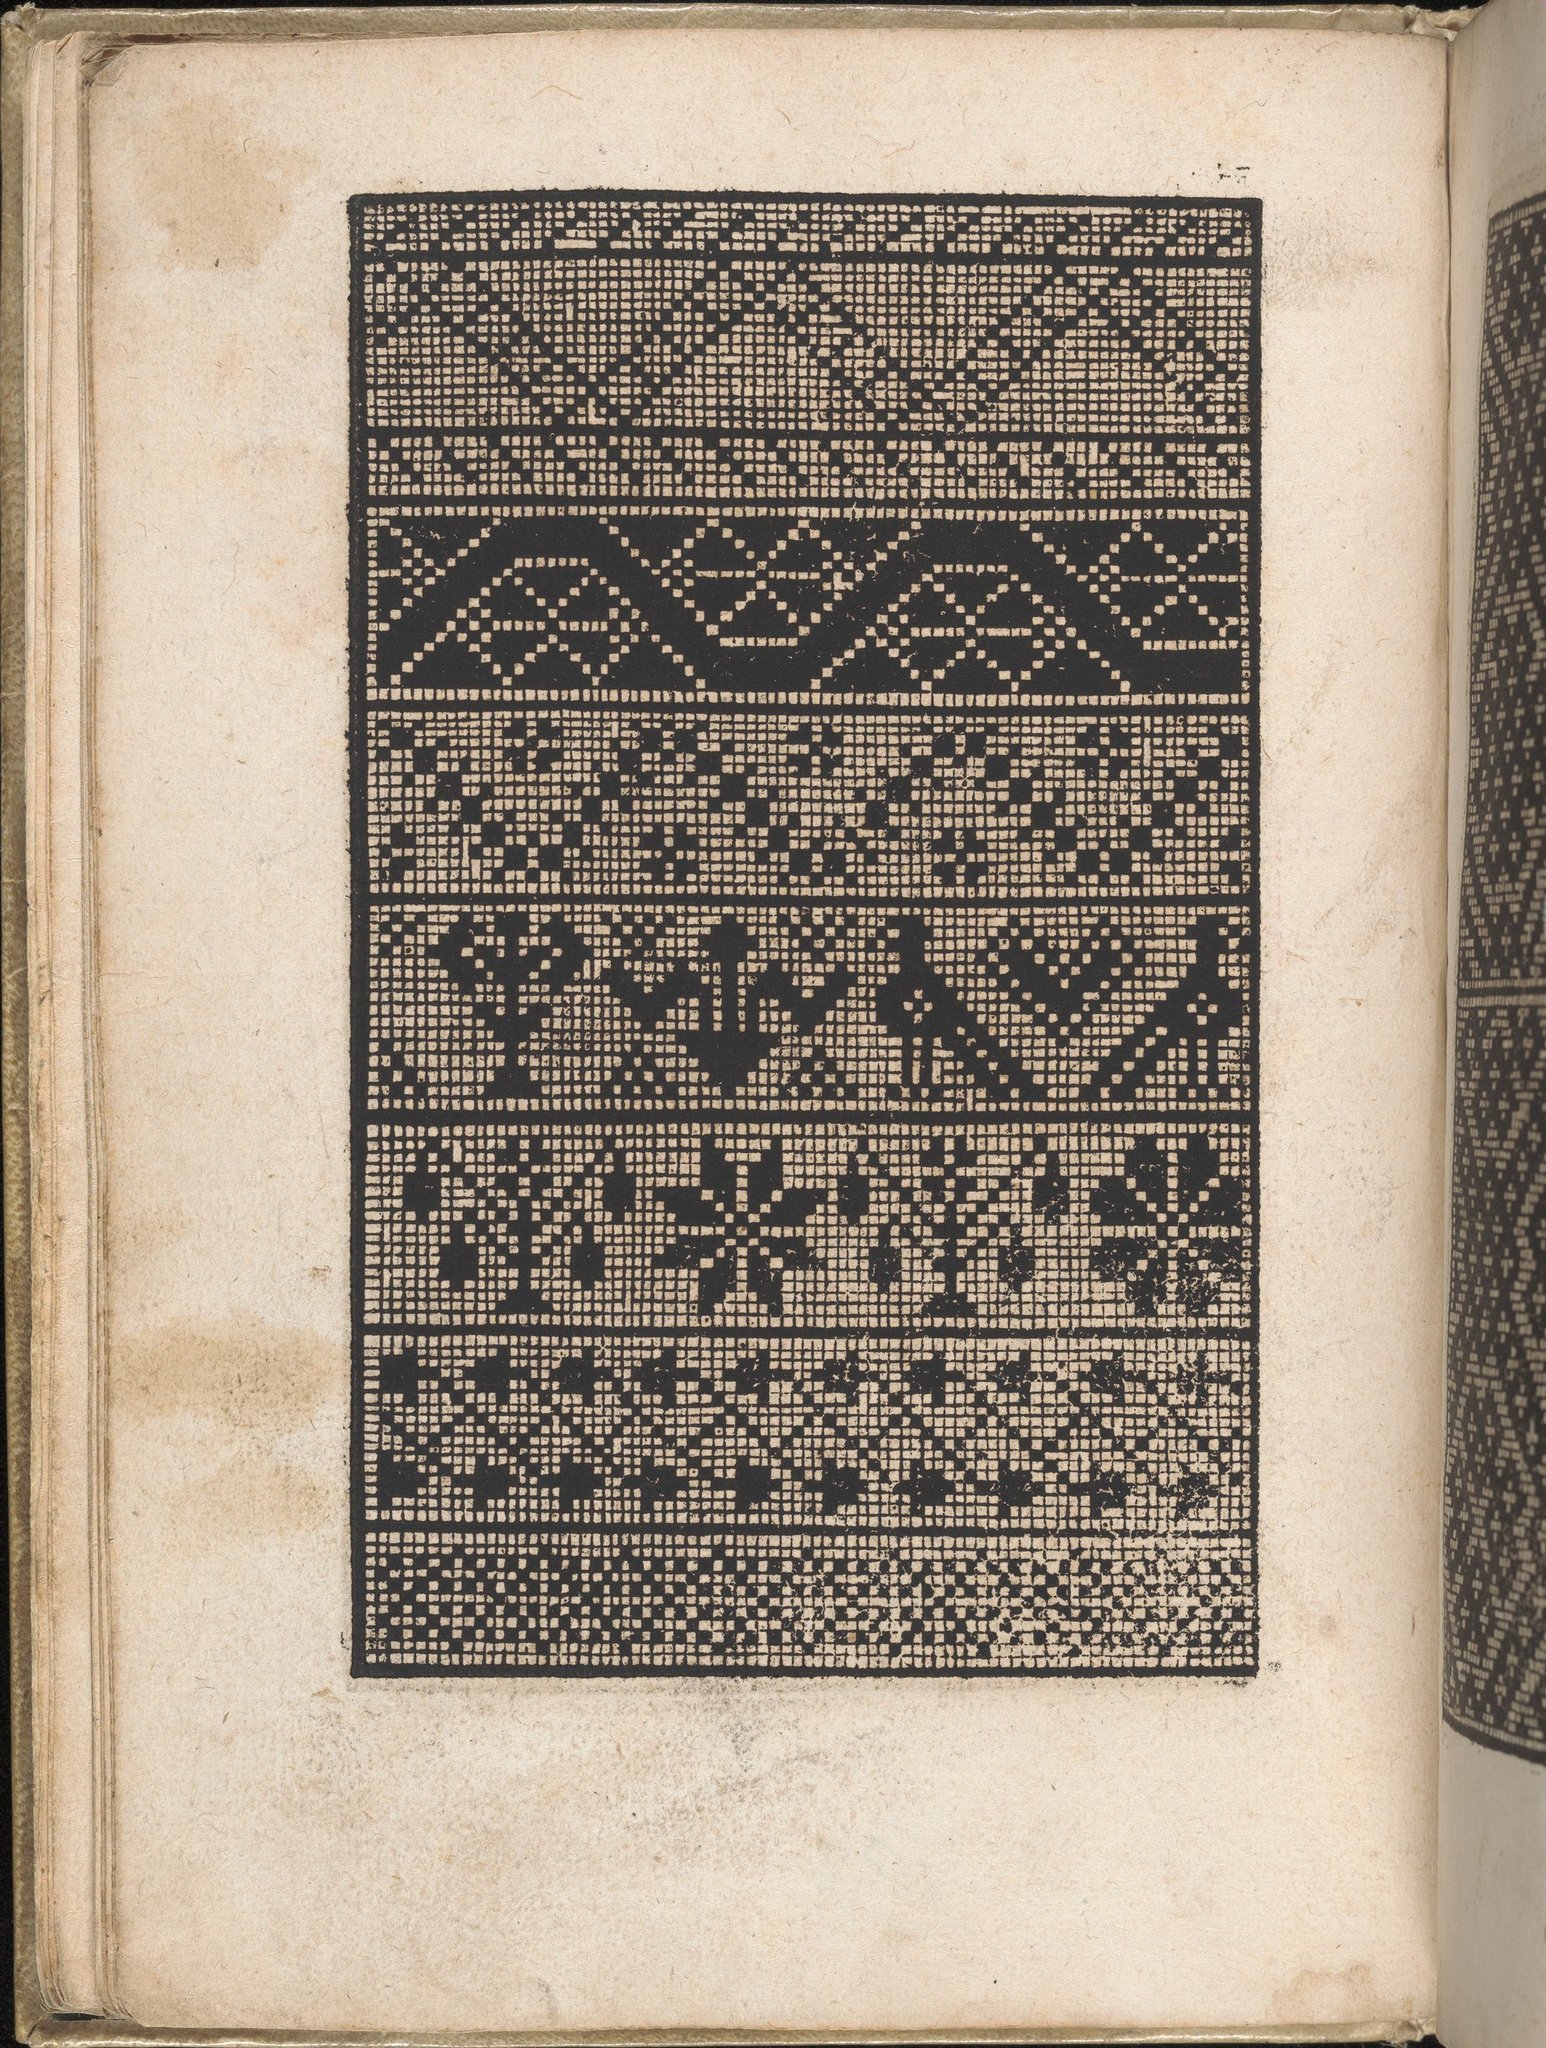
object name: book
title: Page 12v, from "Eyn New Kunstlichboich"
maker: peter quentel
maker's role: publisher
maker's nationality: german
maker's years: 1500-1550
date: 1529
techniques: woodcut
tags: birds,flowers